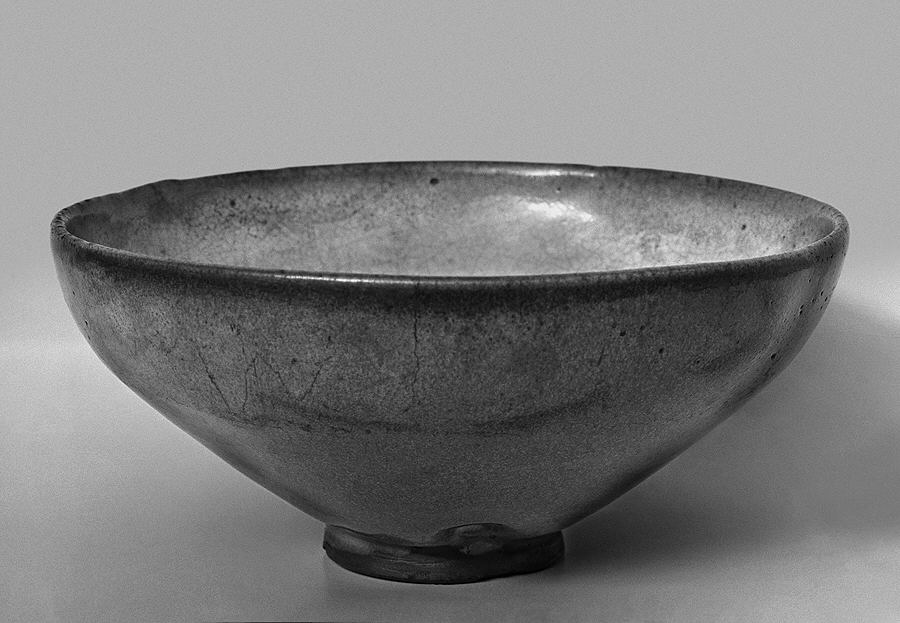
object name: bowl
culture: chinese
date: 1271-1368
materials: pottery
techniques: glazing